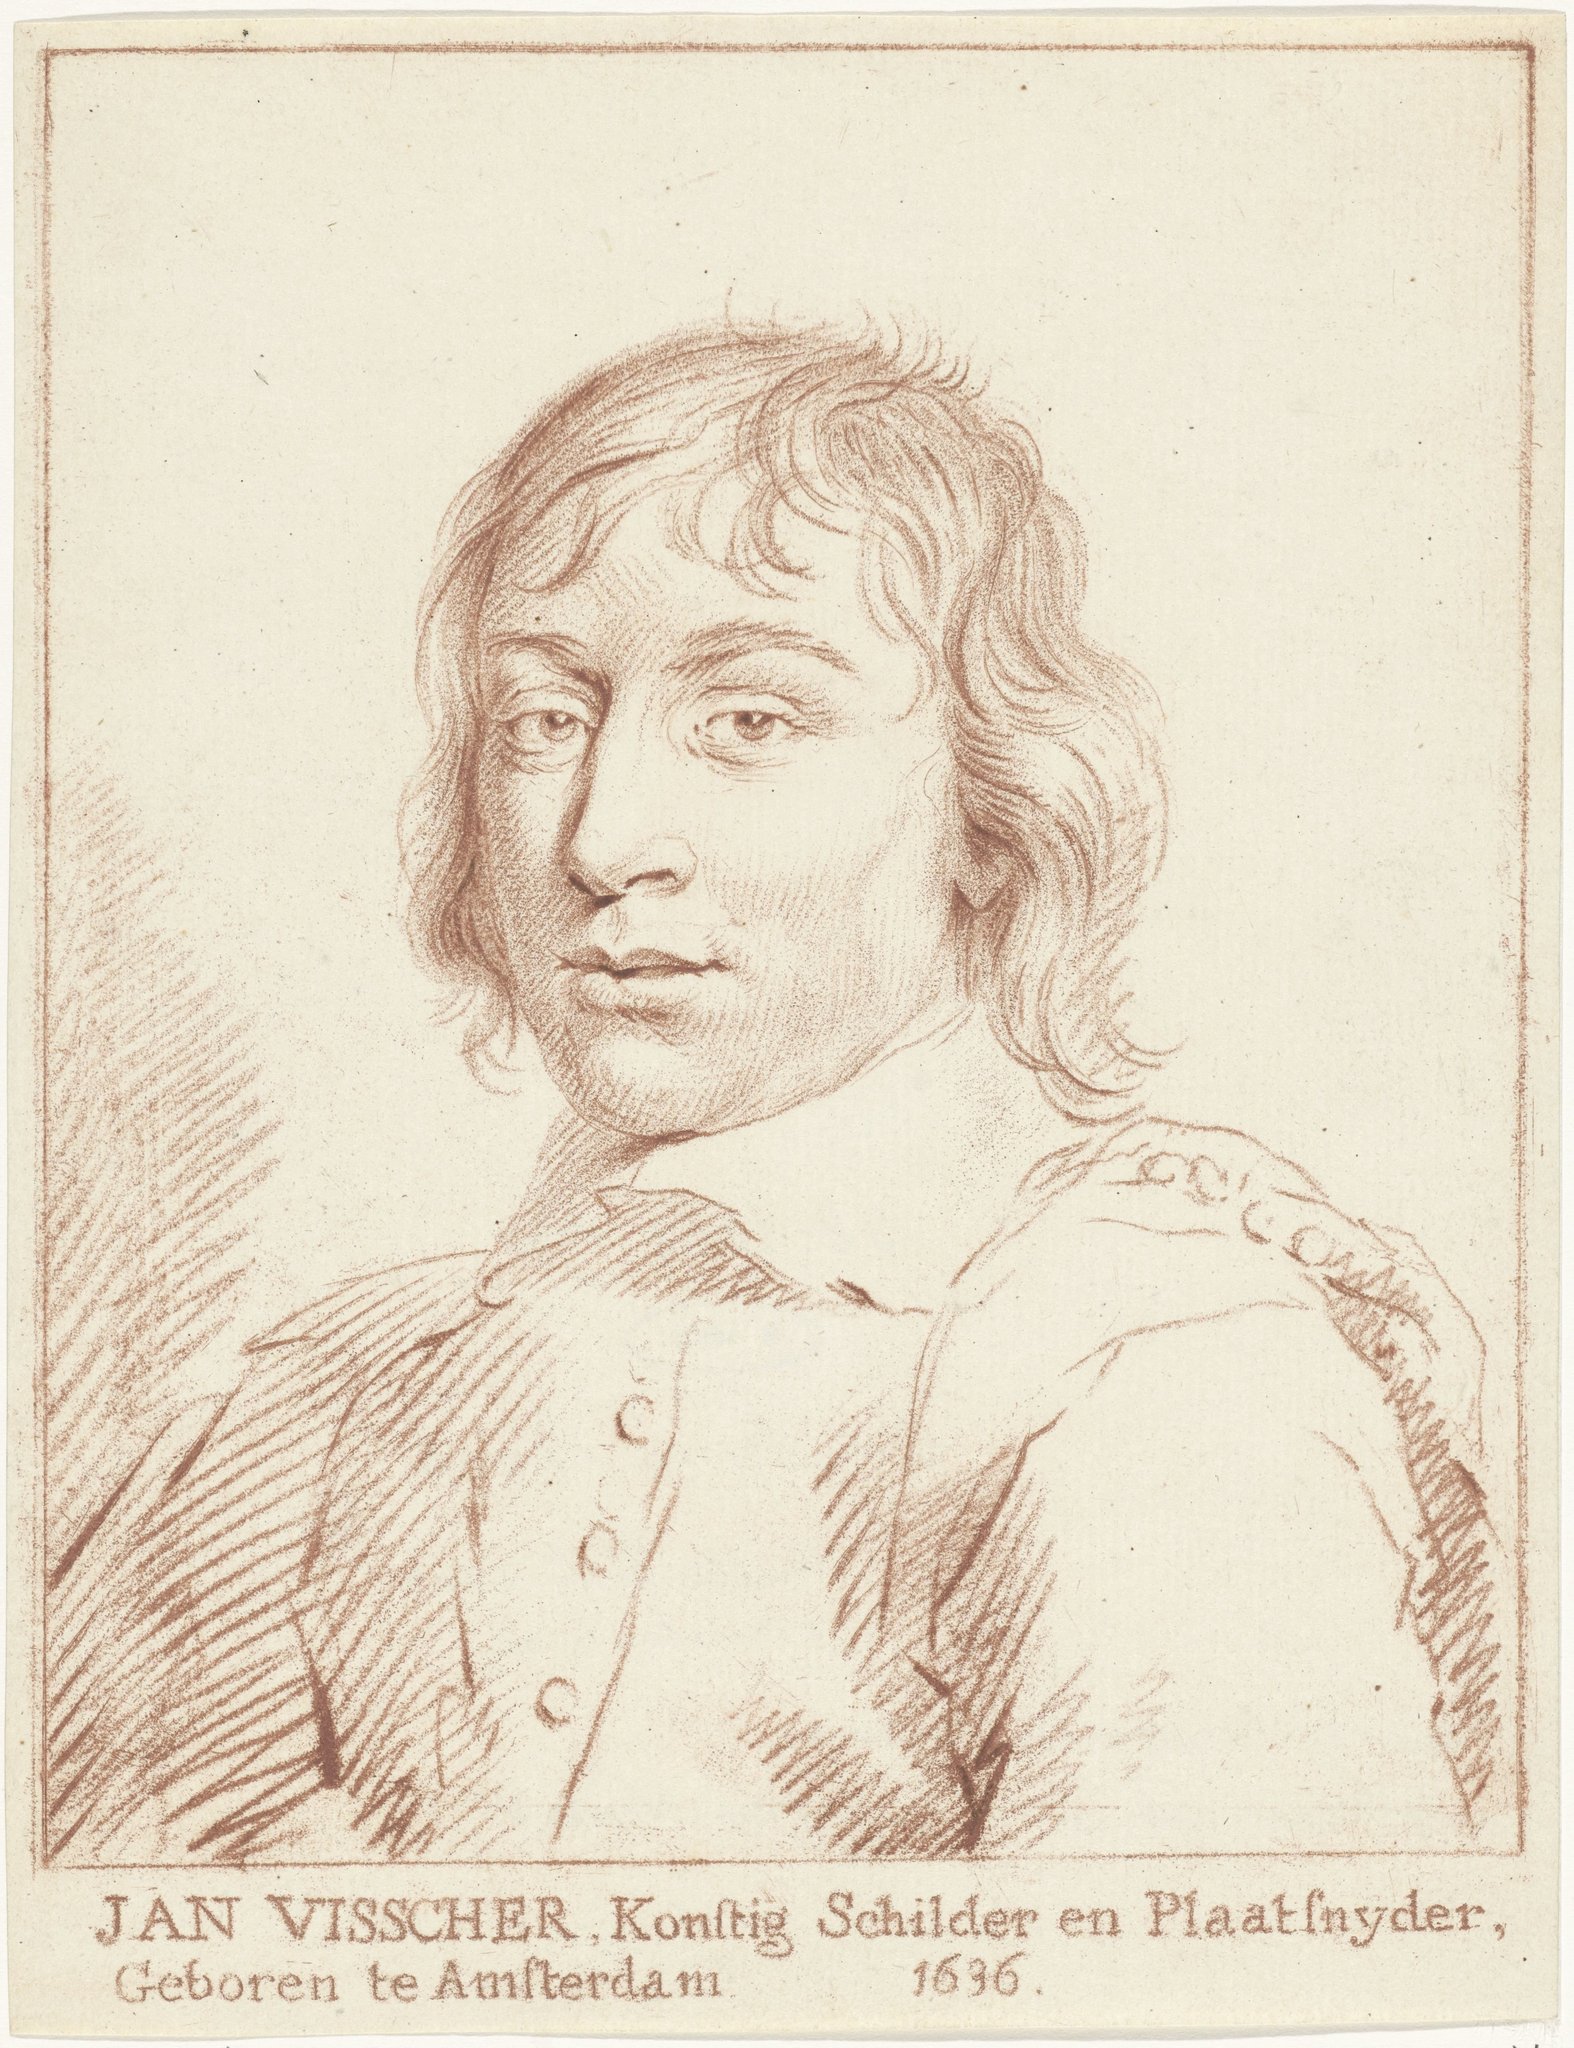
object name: print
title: Portret van Jan de Visscher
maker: cornelis van noorde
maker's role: draughtsman, print maker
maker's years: 1731-1795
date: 1775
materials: paper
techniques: printing, printmaking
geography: haarlem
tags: jan de visscher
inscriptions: collector's mark: Lugt 2760, collector's mark: Lugt 2228, inscription: ‘naar de Origineele Tekening in 't koper gebragt door Corn: van Noorde, 1775.’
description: Portret van schilder en prentmaker Jan de Visscher.